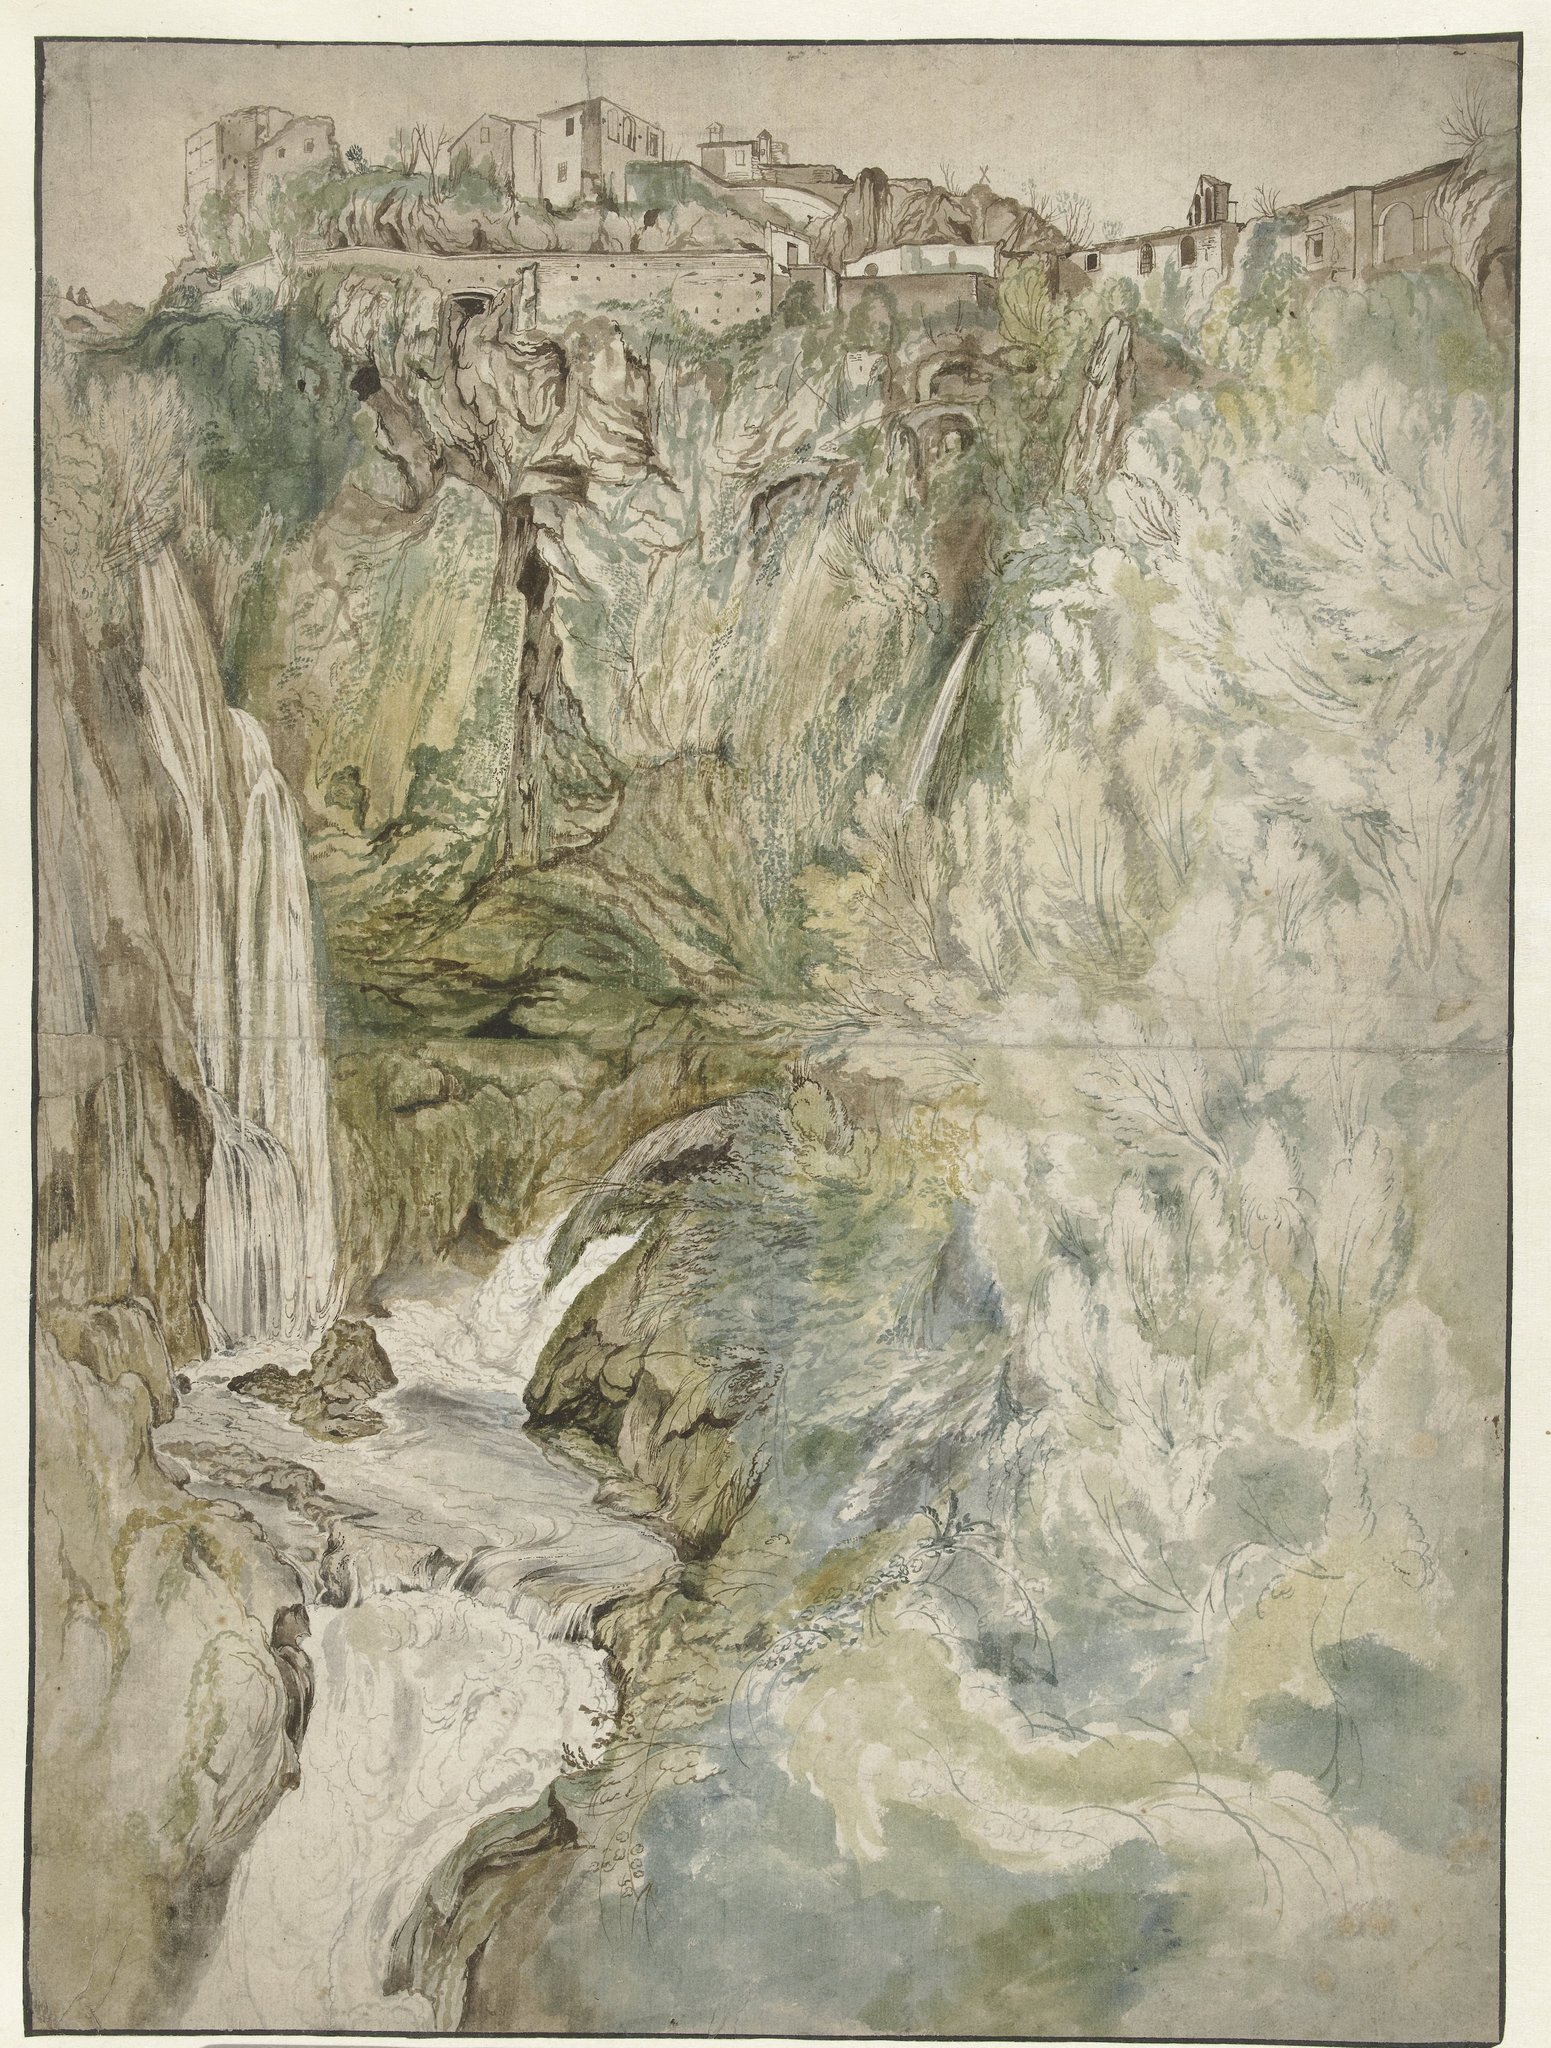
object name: drawing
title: View of the Great Cascade at Tivoli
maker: adriaen honich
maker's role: painter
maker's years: 1643-1674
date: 1667-1683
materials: chalk, paint, ink, paper, watercolor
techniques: brush, pen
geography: rome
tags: waterfall, italy, tivoli